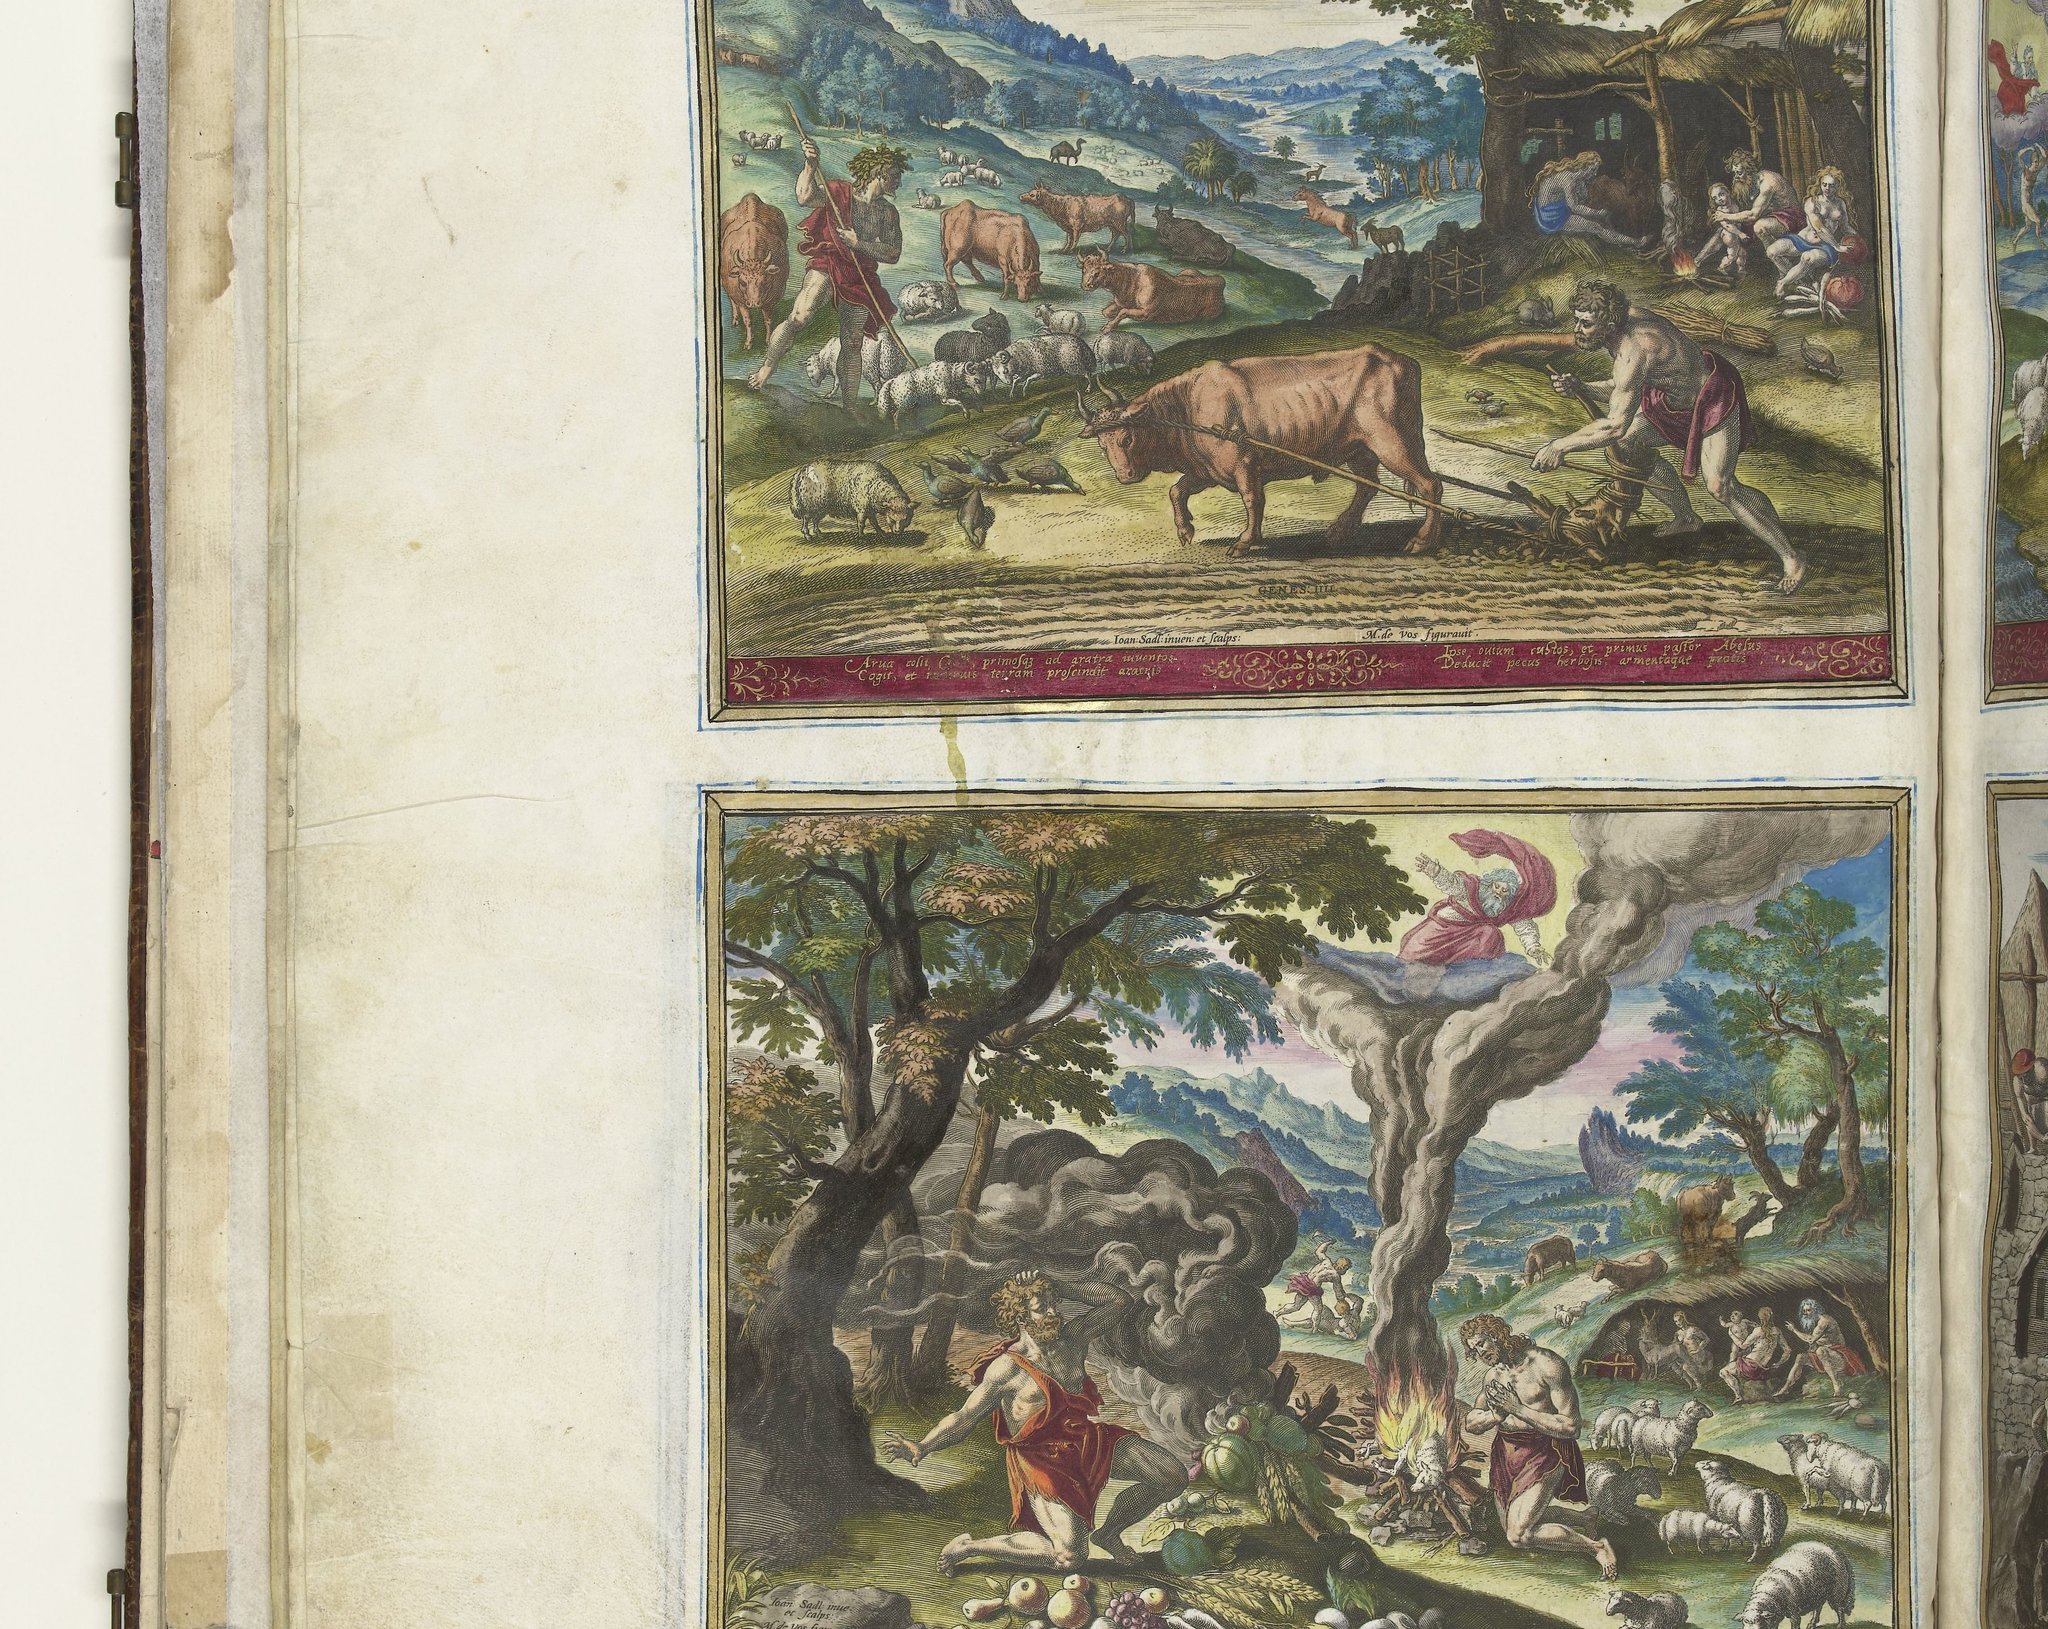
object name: print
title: Offer van Kaïn en Abel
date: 1583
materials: paper, parchment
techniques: engraving, hand coloring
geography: antwerp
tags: the fume of abel's sacrifice goes straight to heaven, whereas the smoke of cain's offering is beaten down, with god blessing abel, the killing of abel: cain slays him with a stone, a club or a jaw-bone, alternatively with a spade or another tool as weapon, the sacrifice of cain and abel: abel offers a lamb, cain usually a sheaf of corn, god the father as bearded old man, usually with crown or tiara or sceptre and/or globe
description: Kaïn en Abel brengen ieder een offer. Op de voorgrond Kaïns offeraltaar, waarop hij korenschoven en vruchten offert. De rook van het offer stijgt niet omhoog. Op de achtergrond, Abels offeraltaar, waarop hij een schaap offert. De rook gaat omhoog. Boven in de lucht verschijnt God in de wolken. God keurt Abels offer goed. Kaïn wordt daarom zo kwaad, dat hij Abel met een kaakbeen wil doodslaan. Op de achtergrond de moord op Abel door zijn broer Kaïn. Rechts de hut van Adam en Eva. Onder de voorstelling een verklarende tekst in het Latijn. Deze prent maakt deel uit van een album.